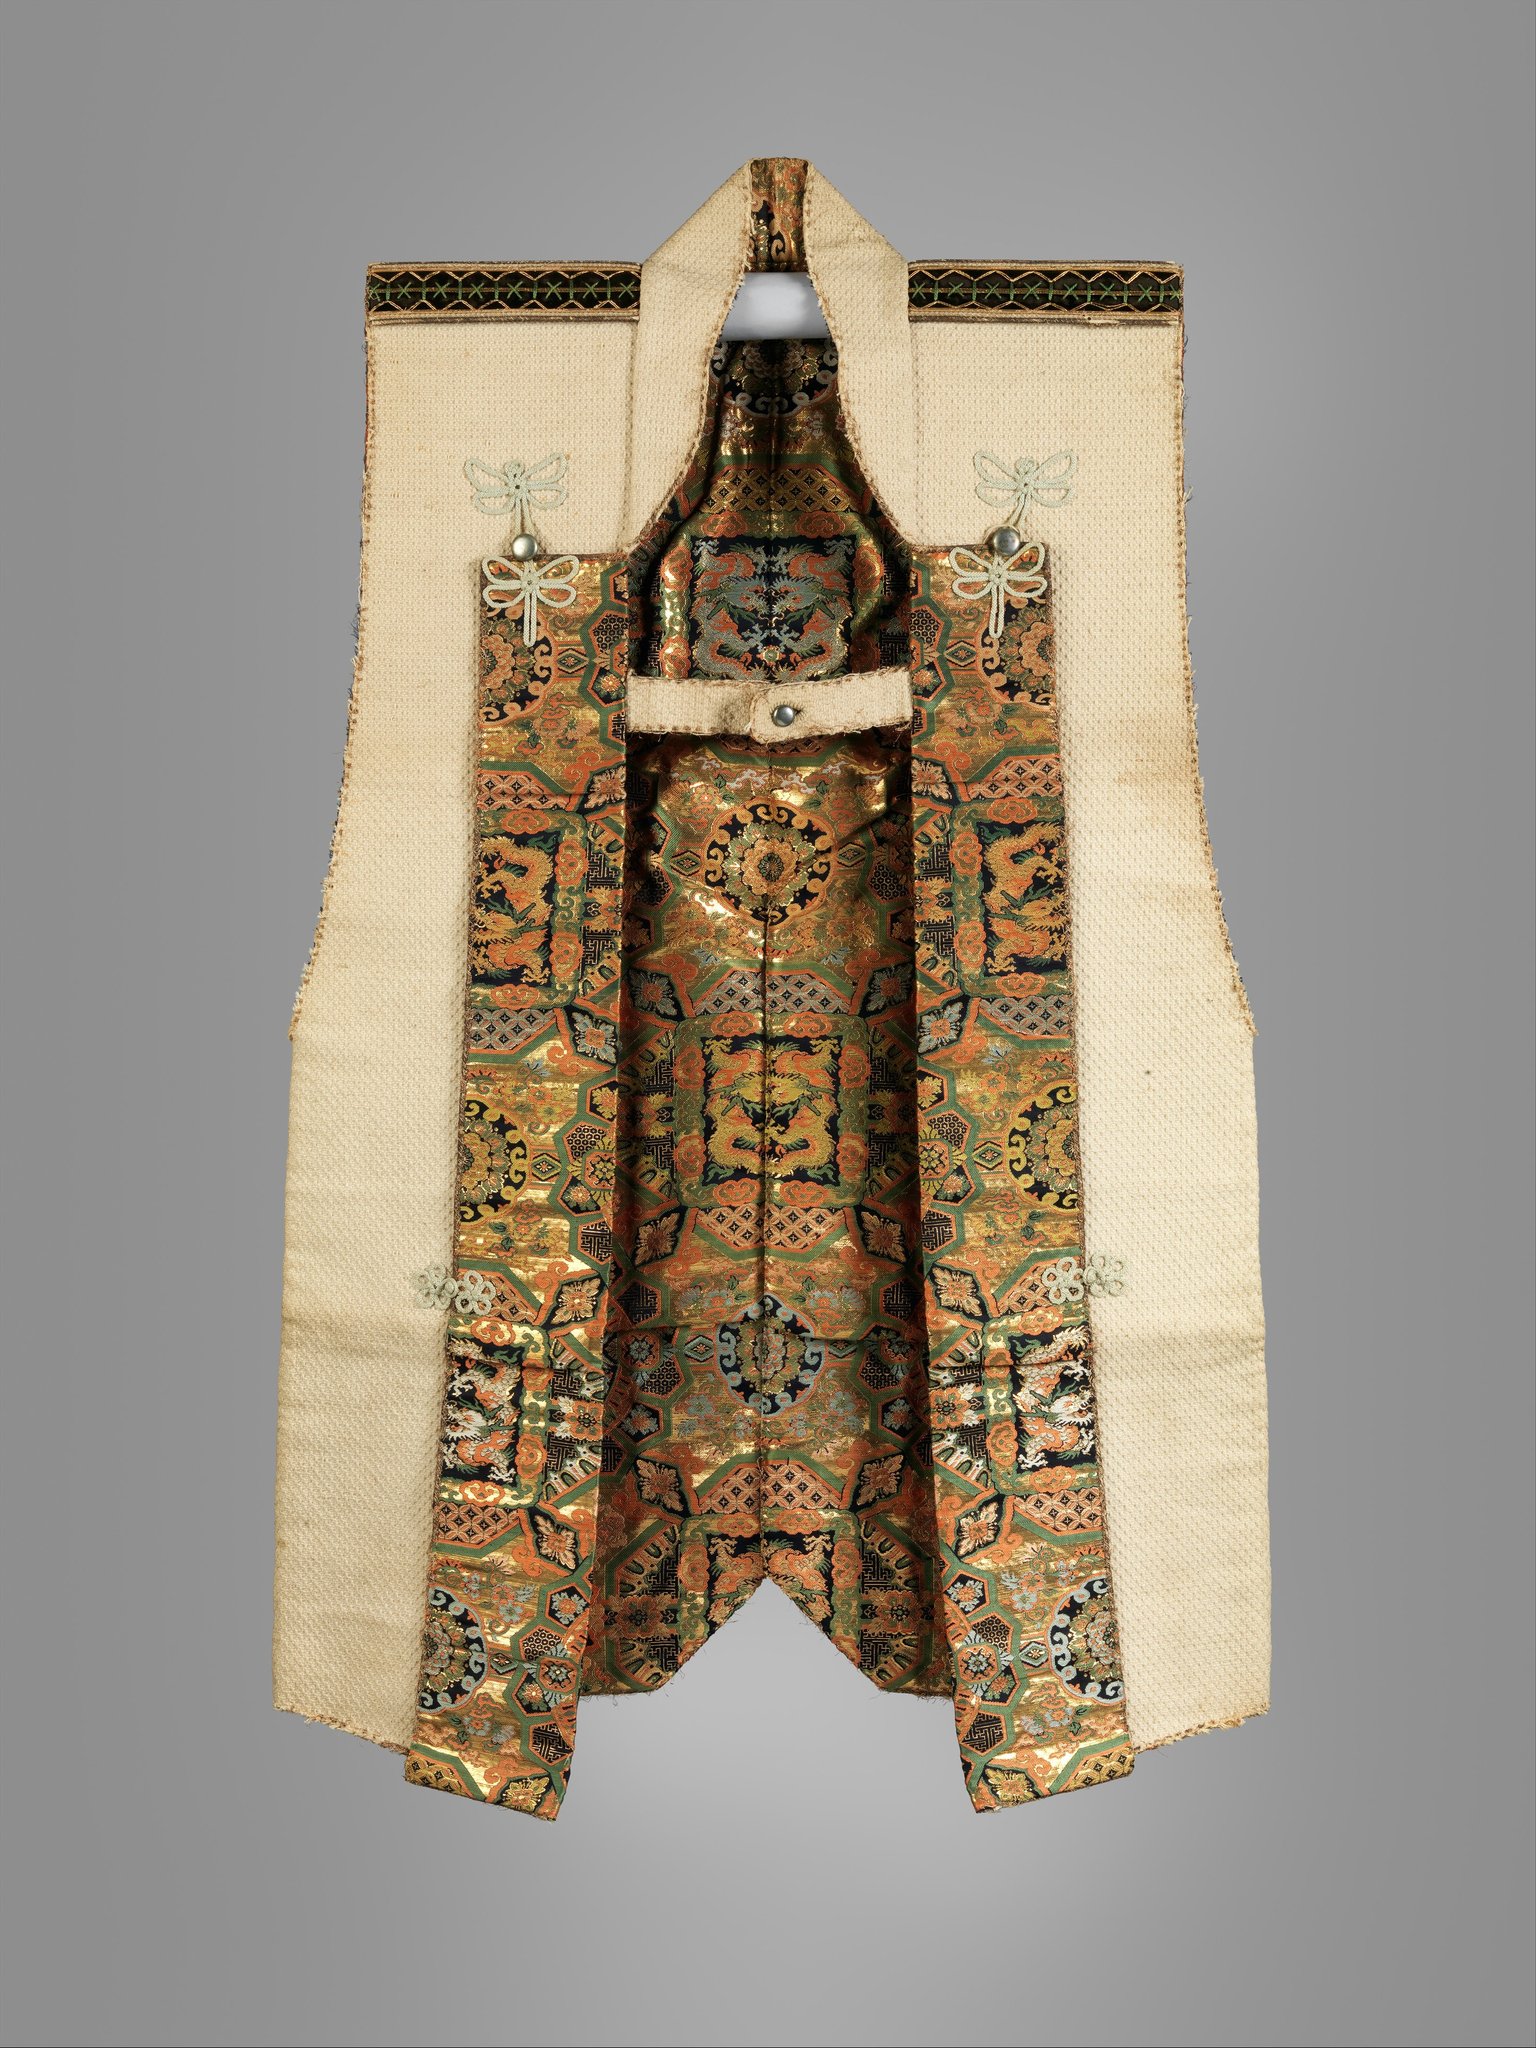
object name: surcoat i jinbaori i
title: Surcoat (Jinbaori)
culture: japanese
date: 1866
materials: cotton, gold, silk, silver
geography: japan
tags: dragons